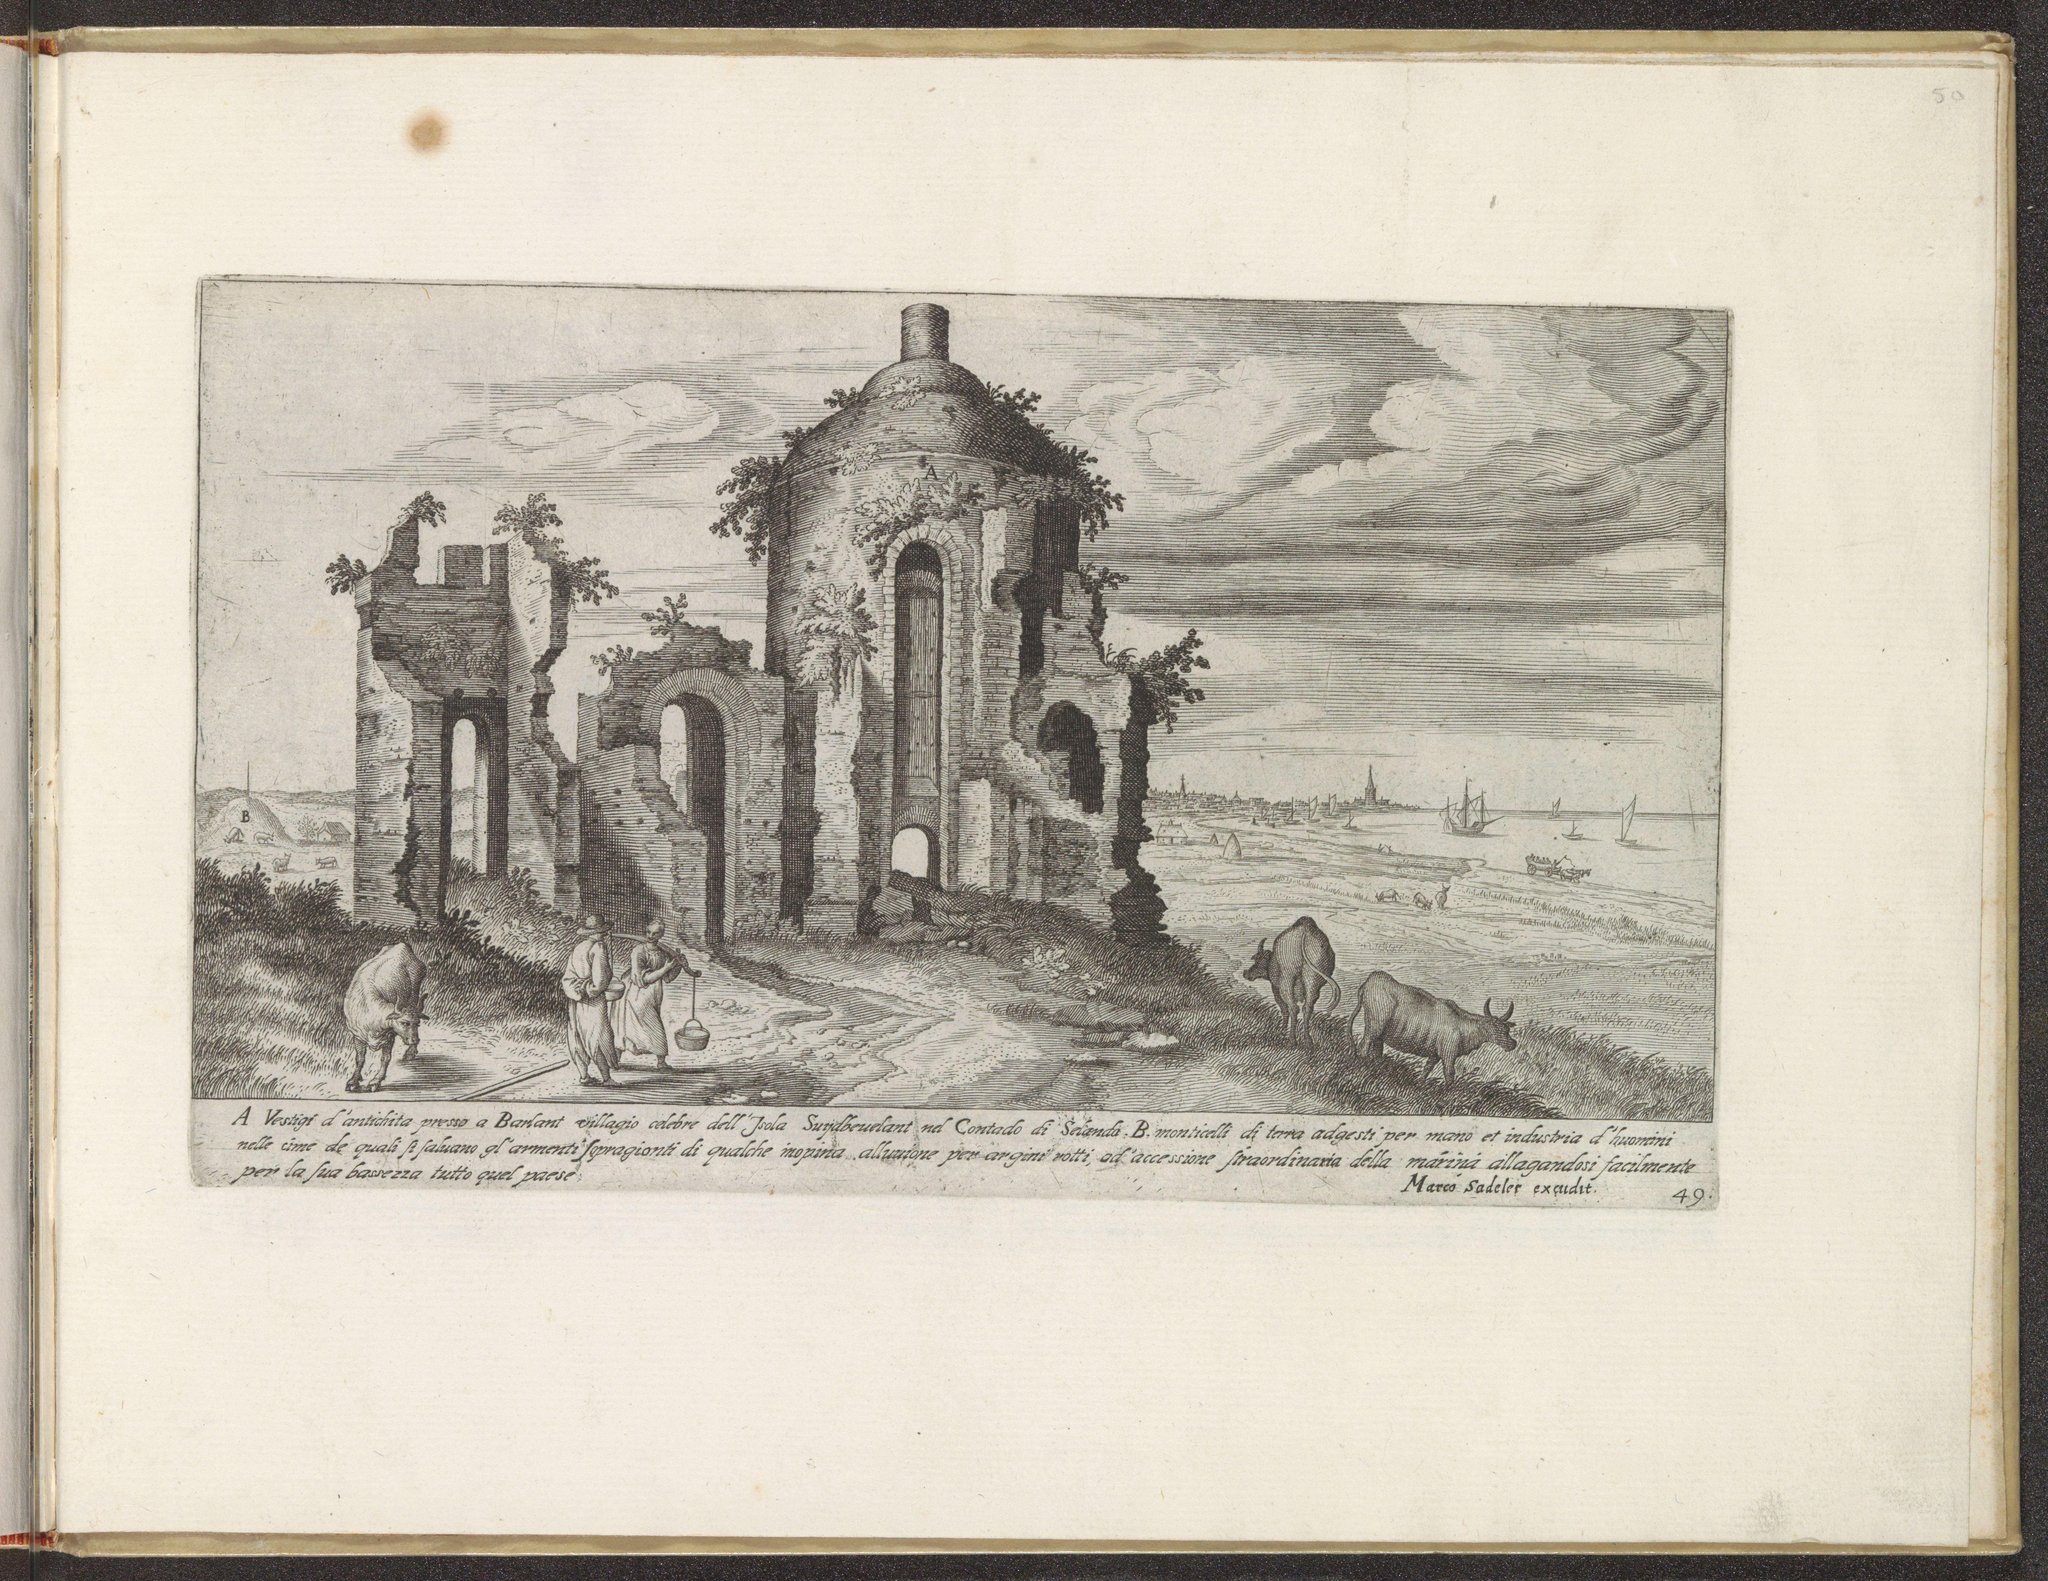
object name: print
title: Rüine bij Baarland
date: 1606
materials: paper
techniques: engraving, etching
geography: prague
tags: zuid-beveland, baarland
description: Volgens het onderschrift overblijfselen van antiquiteiten bij Baarland, gelegen op het platteland in Zuid-Beveland. Op de voorgrond drie koeien, een man en een melkmeisje. Rechts de zee met schepen en een rijtuig op het strand. In de ondermarge drie regels tekst in het Italiaans. De prent maakt deel uit van een album.